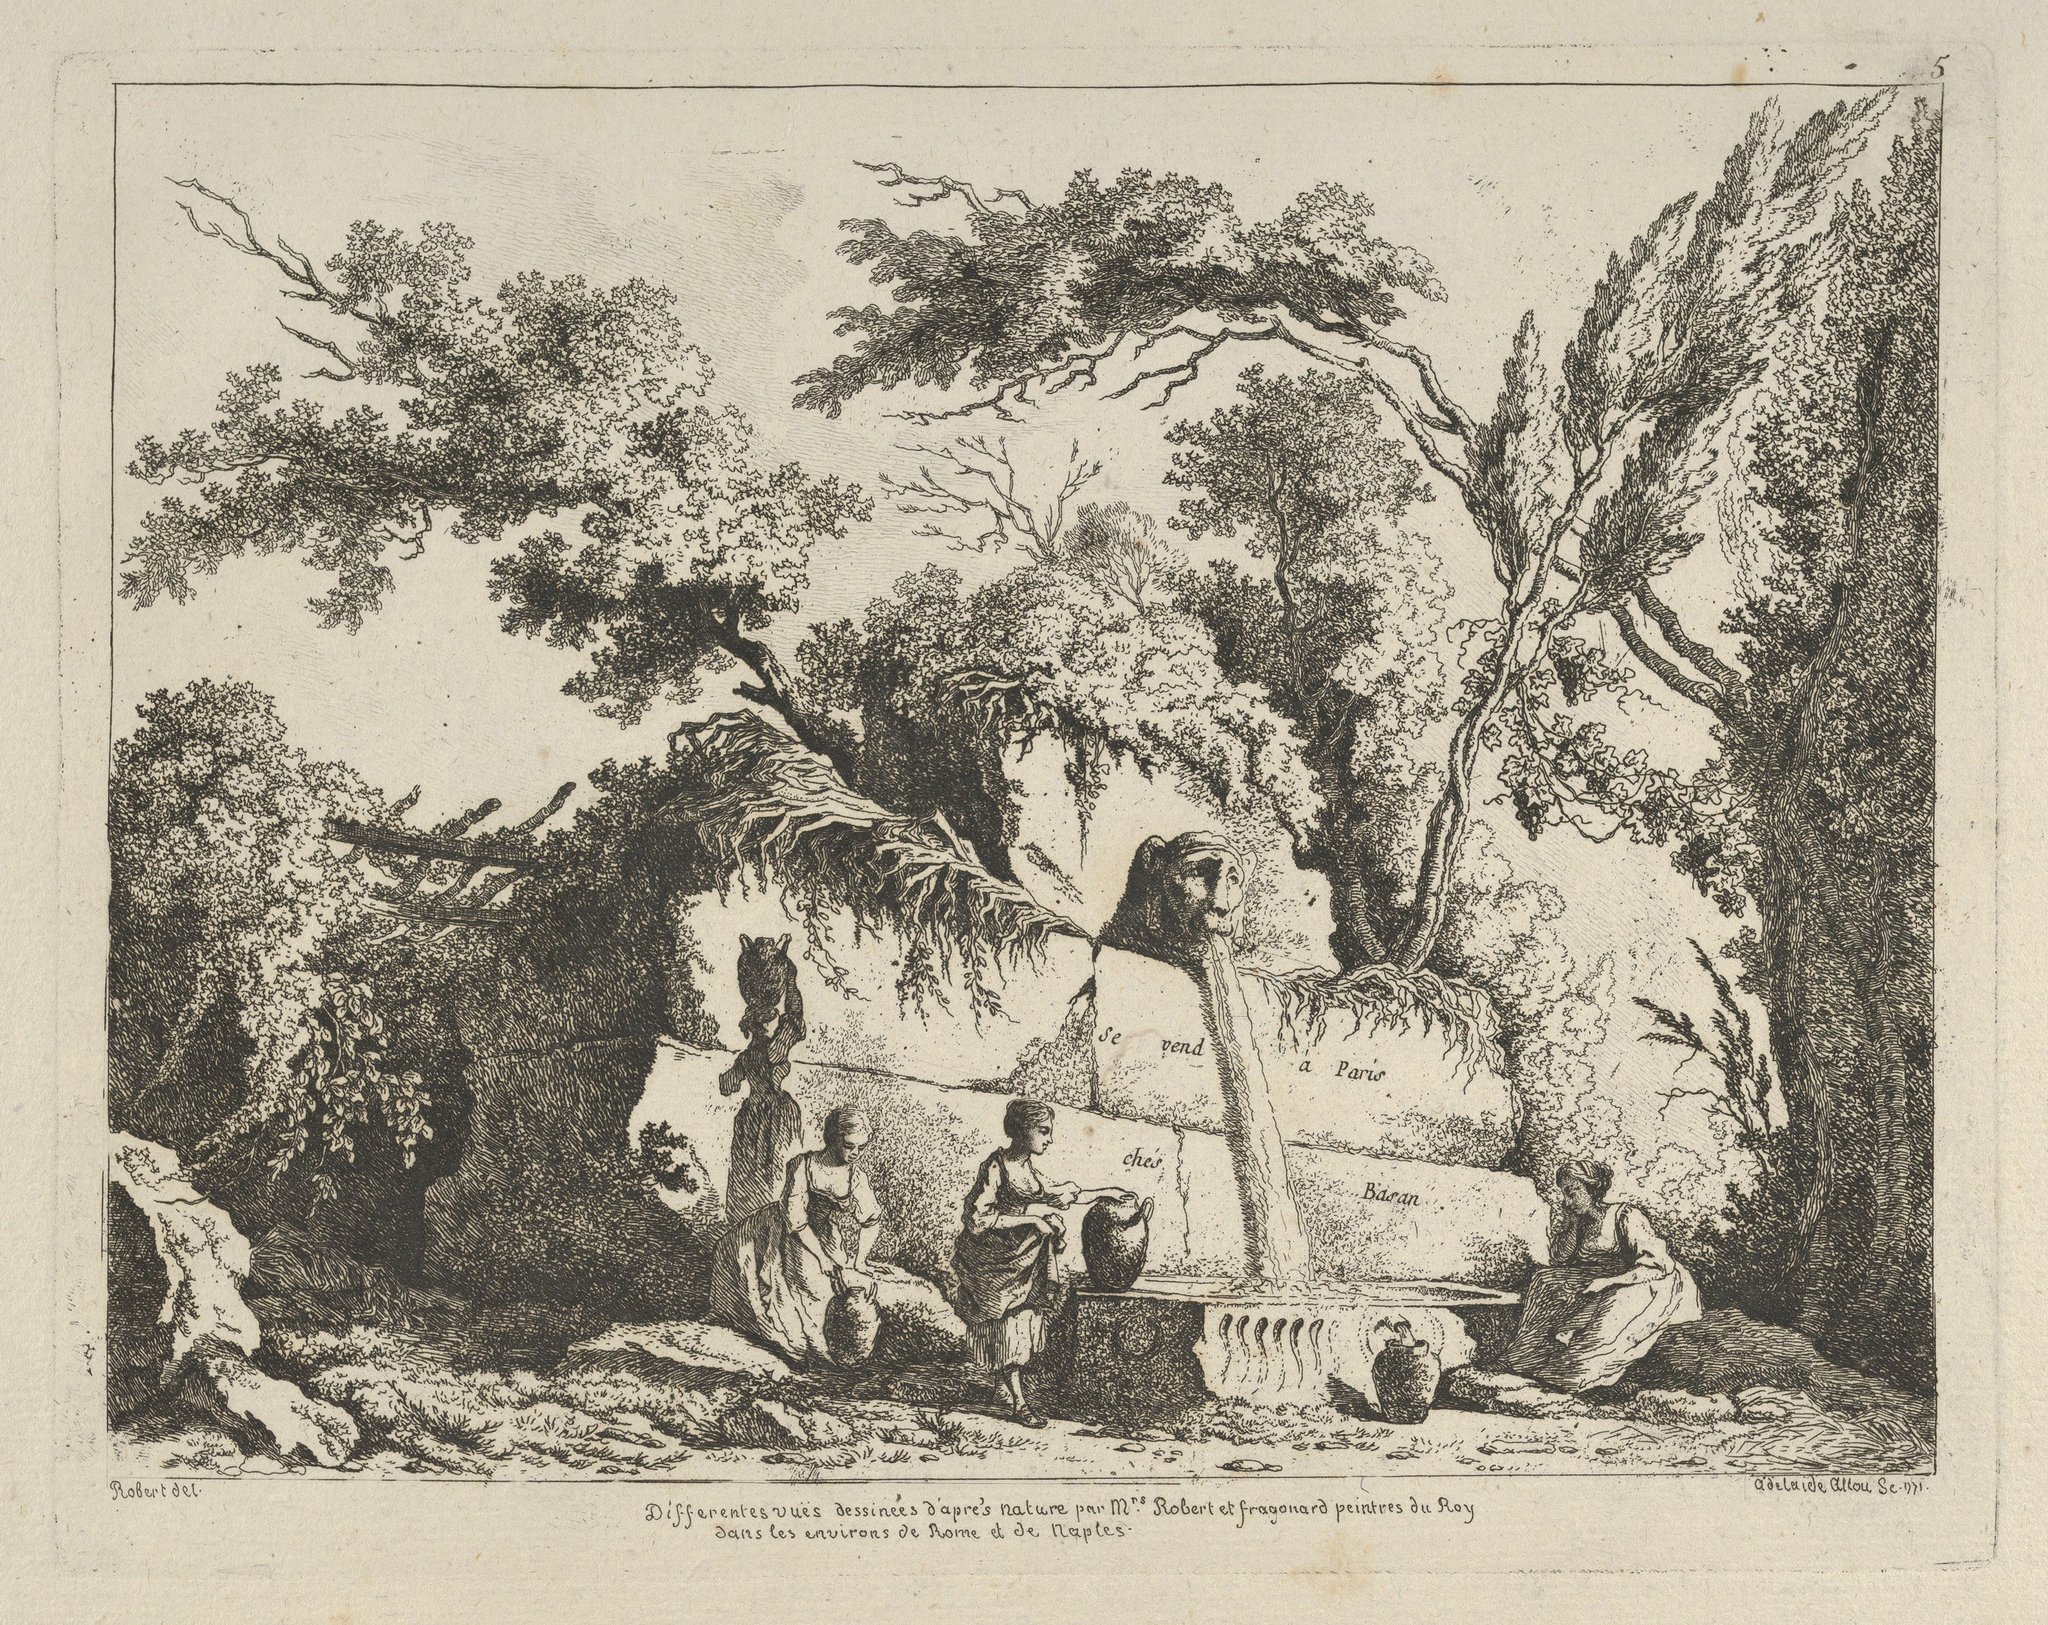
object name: print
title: Titlepage from Differentes vues dessiné d'après nature... dans les environs de Rome et de Naples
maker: adélaide allou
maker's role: artist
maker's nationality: french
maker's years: 1776-1800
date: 1701-1800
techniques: etching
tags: fountains,women